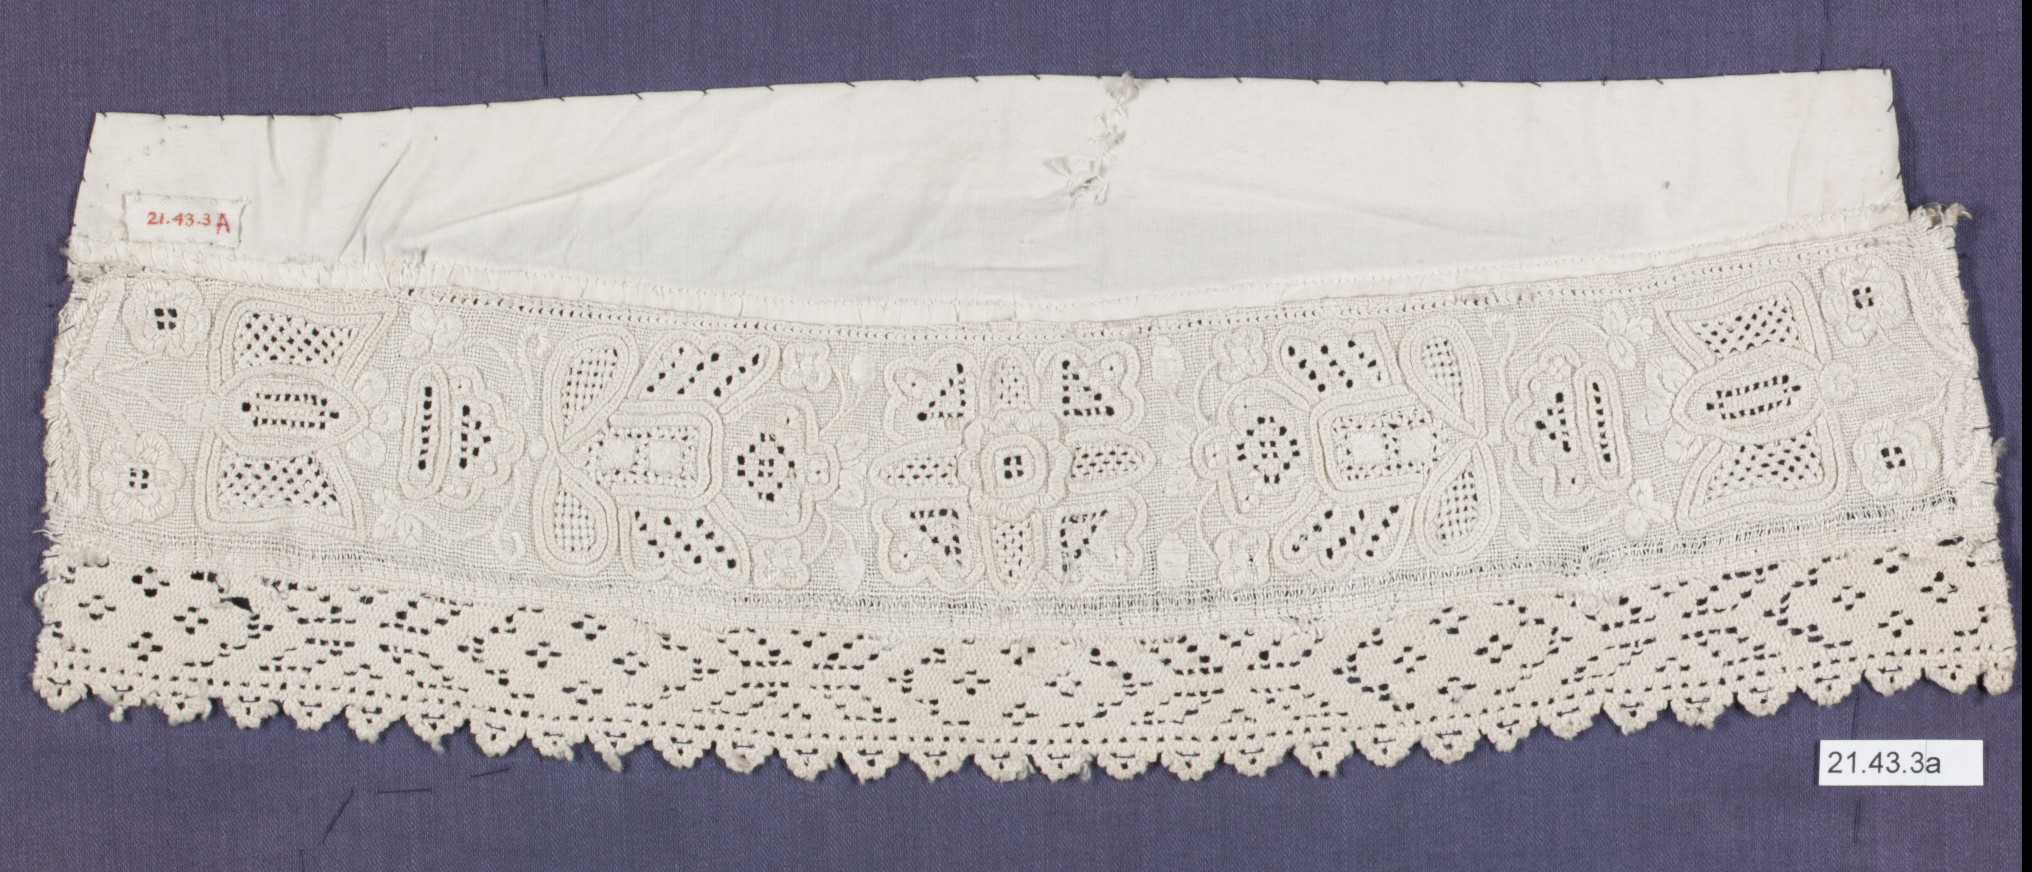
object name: cuff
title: Pair of cuffs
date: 1701-1800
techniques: embroidery